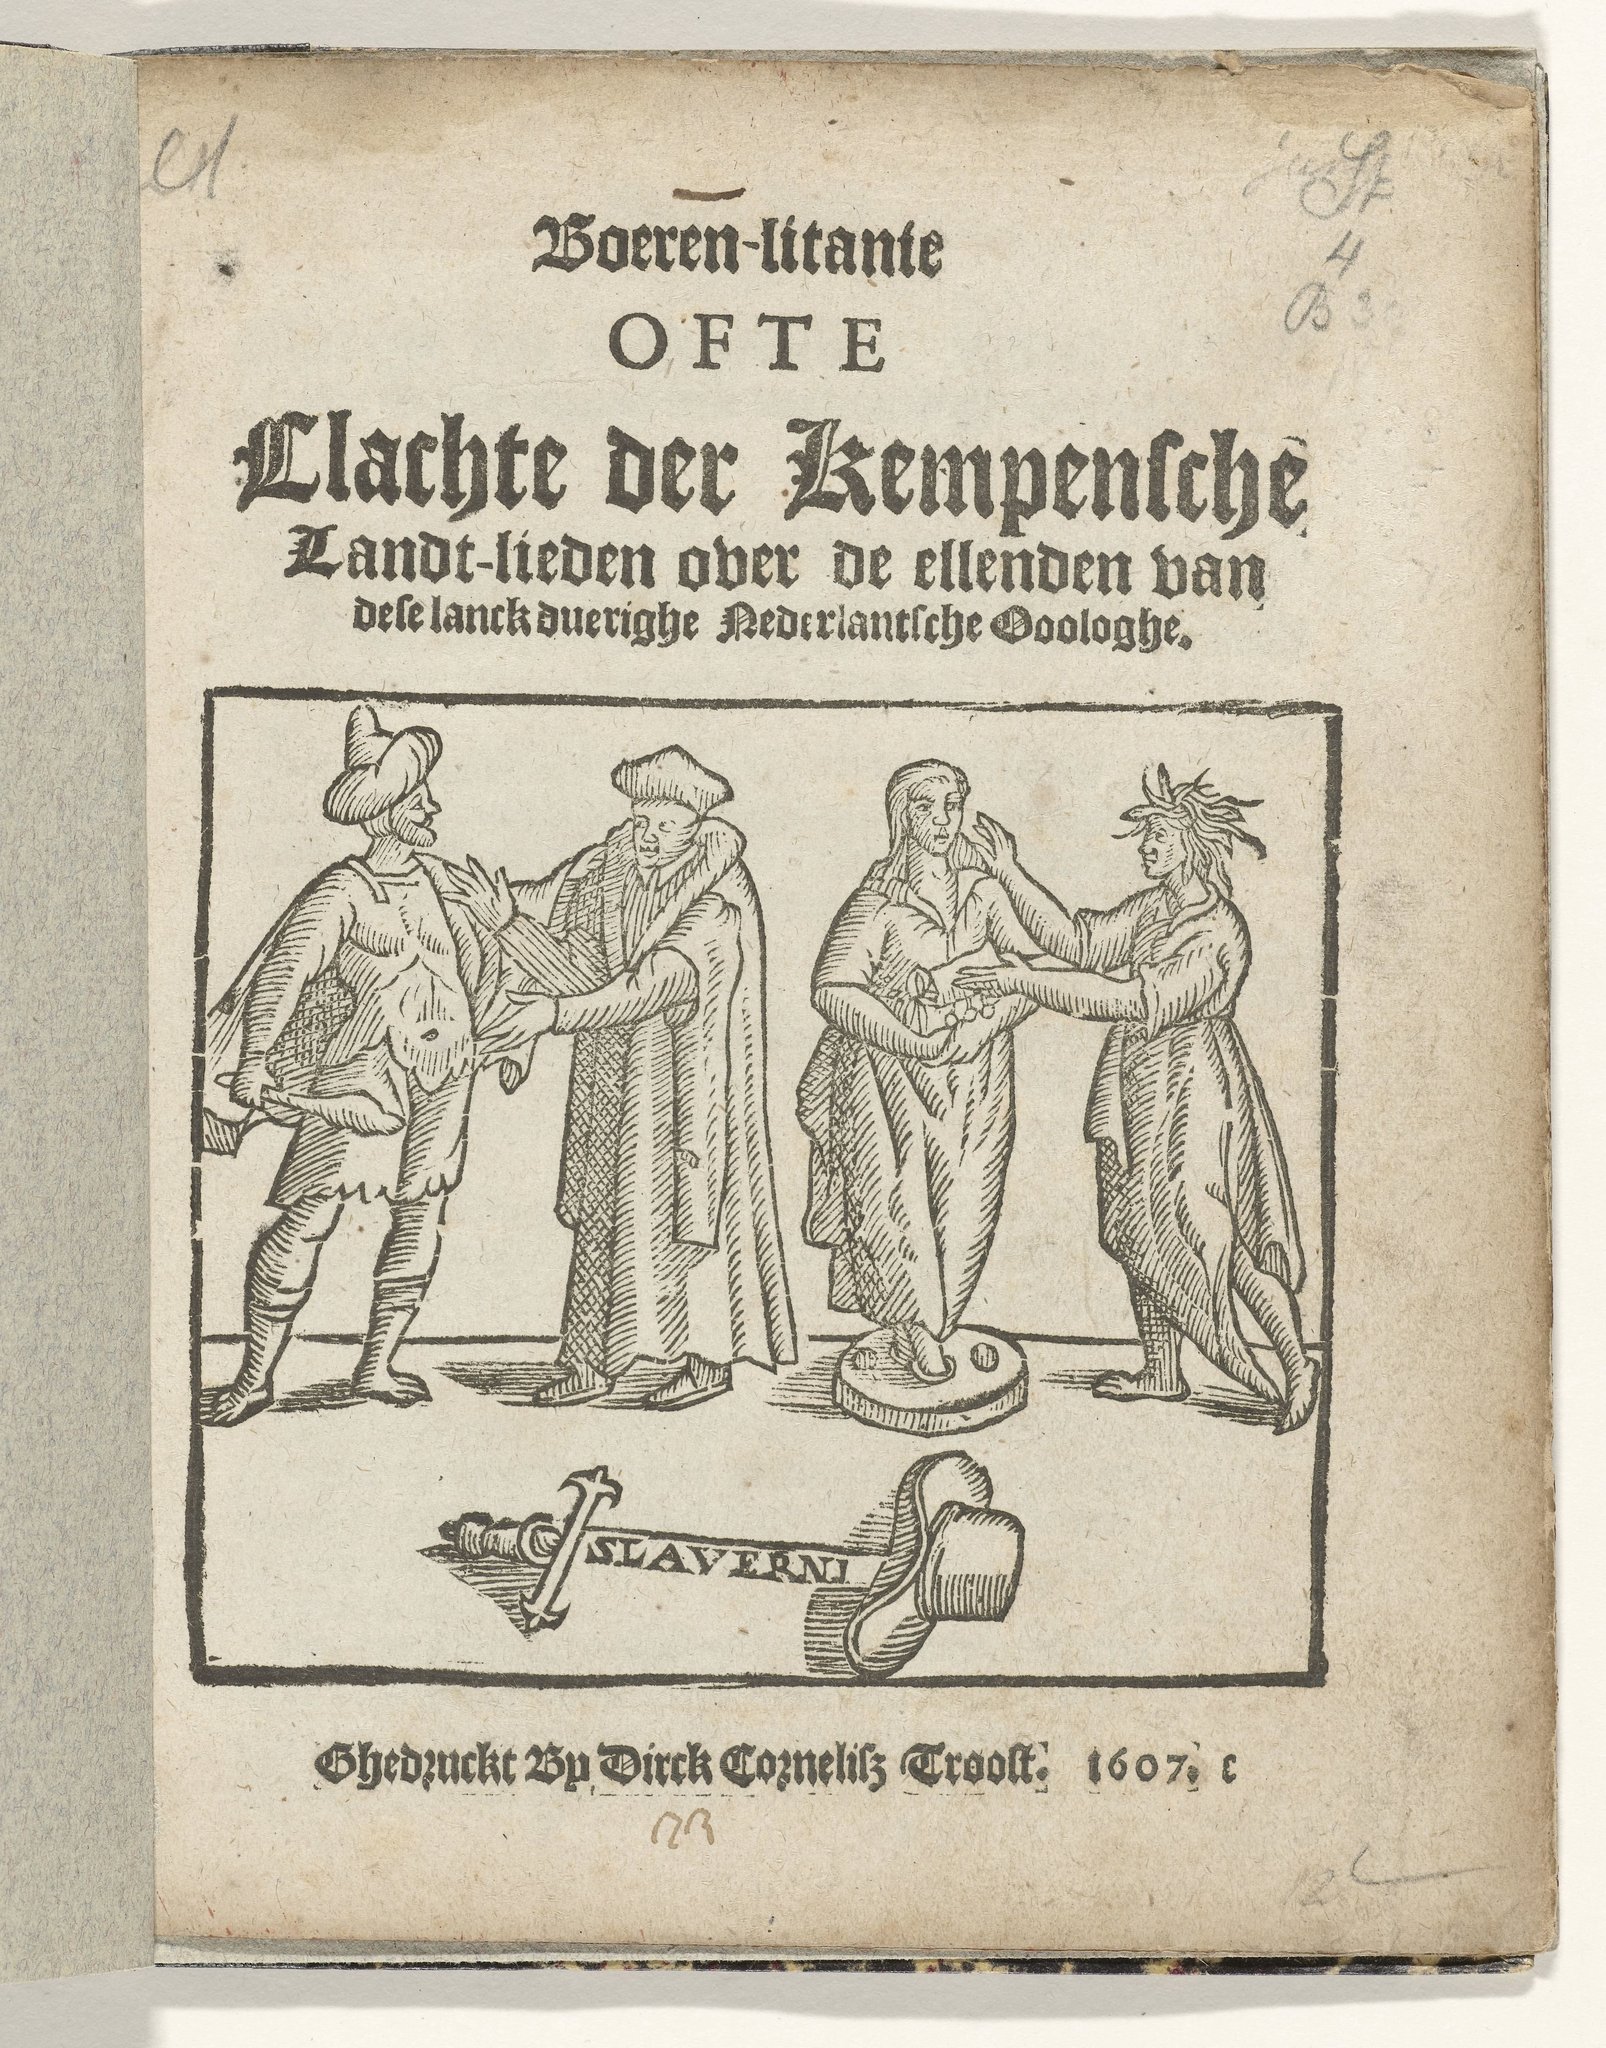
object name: pamphlet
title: Titelpagina van het pamflet: Boeren-Litanie ofte Clachte der Kempensche Landt-lieden over de ellenden van deze lanck duerighe Nederlantsche Ooologhe, 1607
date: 1607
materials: paper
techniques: letterpress printing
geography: northern netherlands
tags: onderhandelingen voor het twaalfjarig bestand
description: Titelpagina van het pamflet Boeren-Litanie ofte Clachte der Kempensche Landt-lieden, met een allegorie tegen de Spaanse vredesvoorstellen, 1607. Twee mannen (een Turk met tulband en knots en een geleerde) en twee vrouwen (Nederland of Vrijheid met privileges en Tweedracht met slangenhaar) tegenover elkaar. Op de grond liggen het zwaard en de hoed van de vrijheid, hier aangeduid als slavernij.